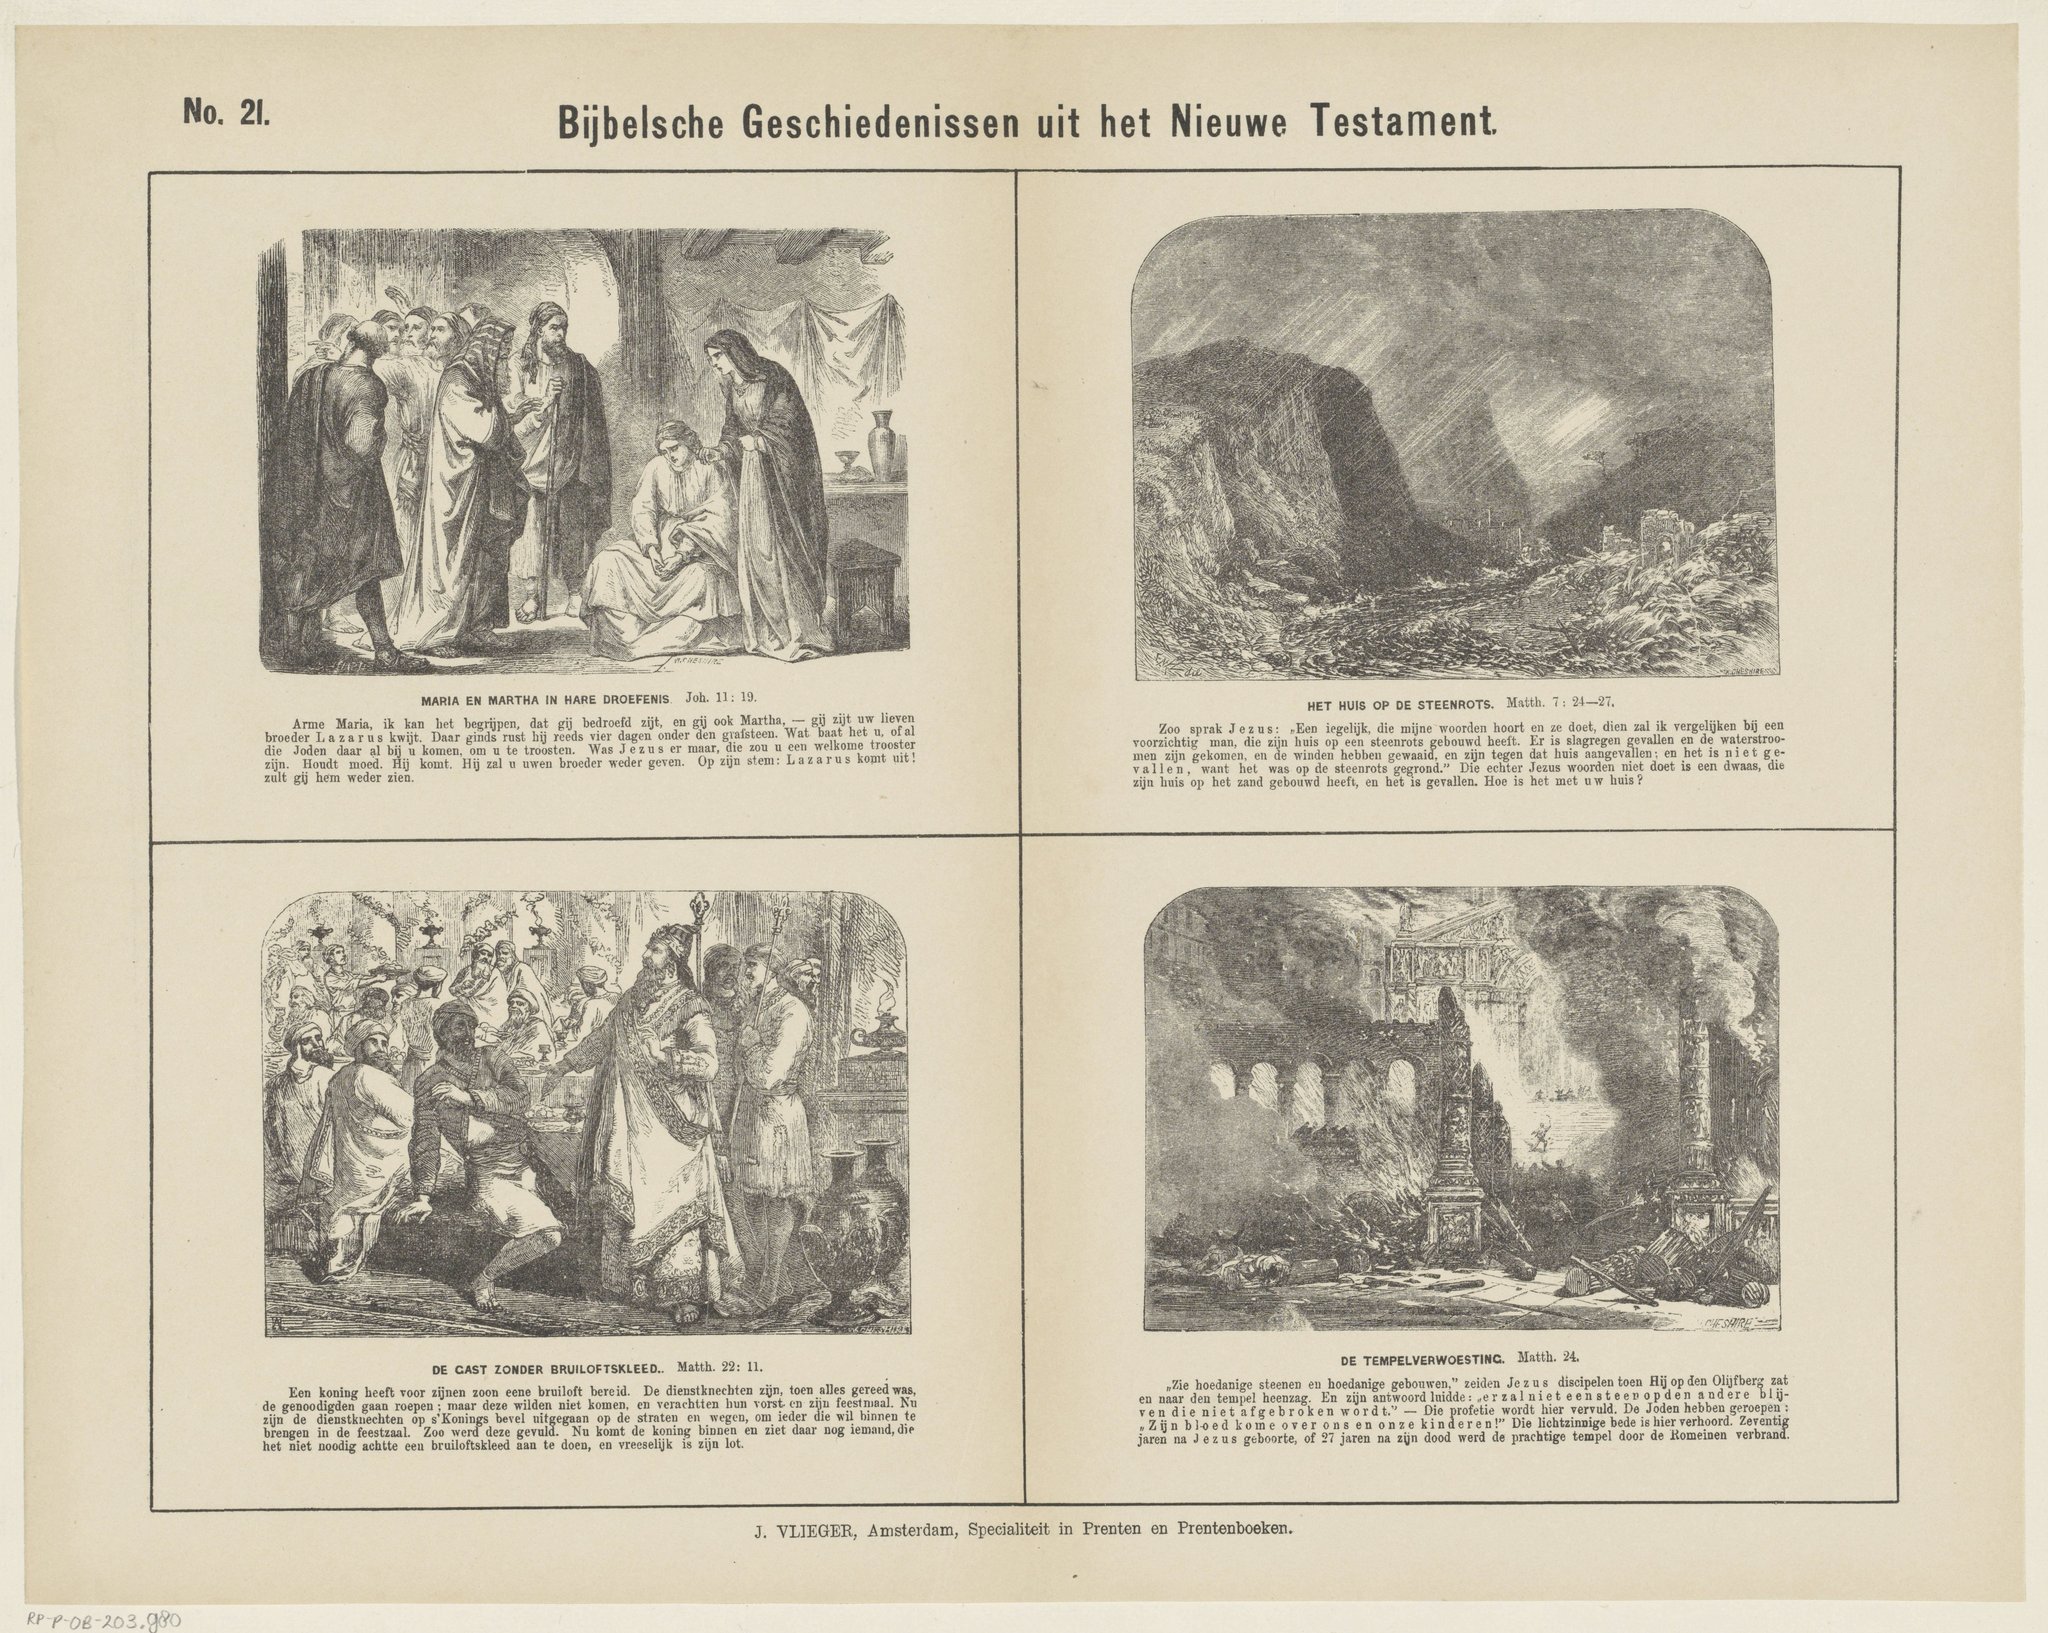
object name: print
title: Bijbelsche geschiedenissen uit het Nieuwe Testament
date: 1871-1908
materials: paper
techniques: letterpress printing, engraving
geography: amsterdam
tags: house built upon a rock; house built upon sand ~ doctrine of christ on love, etc. (matthew 7:24-27; luke 6:47-49), destruction of the temple ~ jewish religion, the brother of st. martha and st. mary magdalene, lazarus of bethany, bishop of marseilles; possible attributes: bishop's garment, book - martyrdom, suffering, misfortune, death of male saint, old testament, the king sees a guest without a wedding garment: 'bind him hand and foot .. and cast him into the outer darkness' ~ parable of the royal wedding-feast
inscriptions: collector's mark: Lugt 2760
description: Blad met 4 voorstellingen van verhalen uit het Nieuwe Testament. Marta en Maria treuren om de dood van hun broer, het huis op de rots, de gast zonder bruiloftskleren en de verwoesting van de tempel. Onder elke afbeelding de bijbehorende Bijbeltekst. Genummerd linksboven: No. 21.